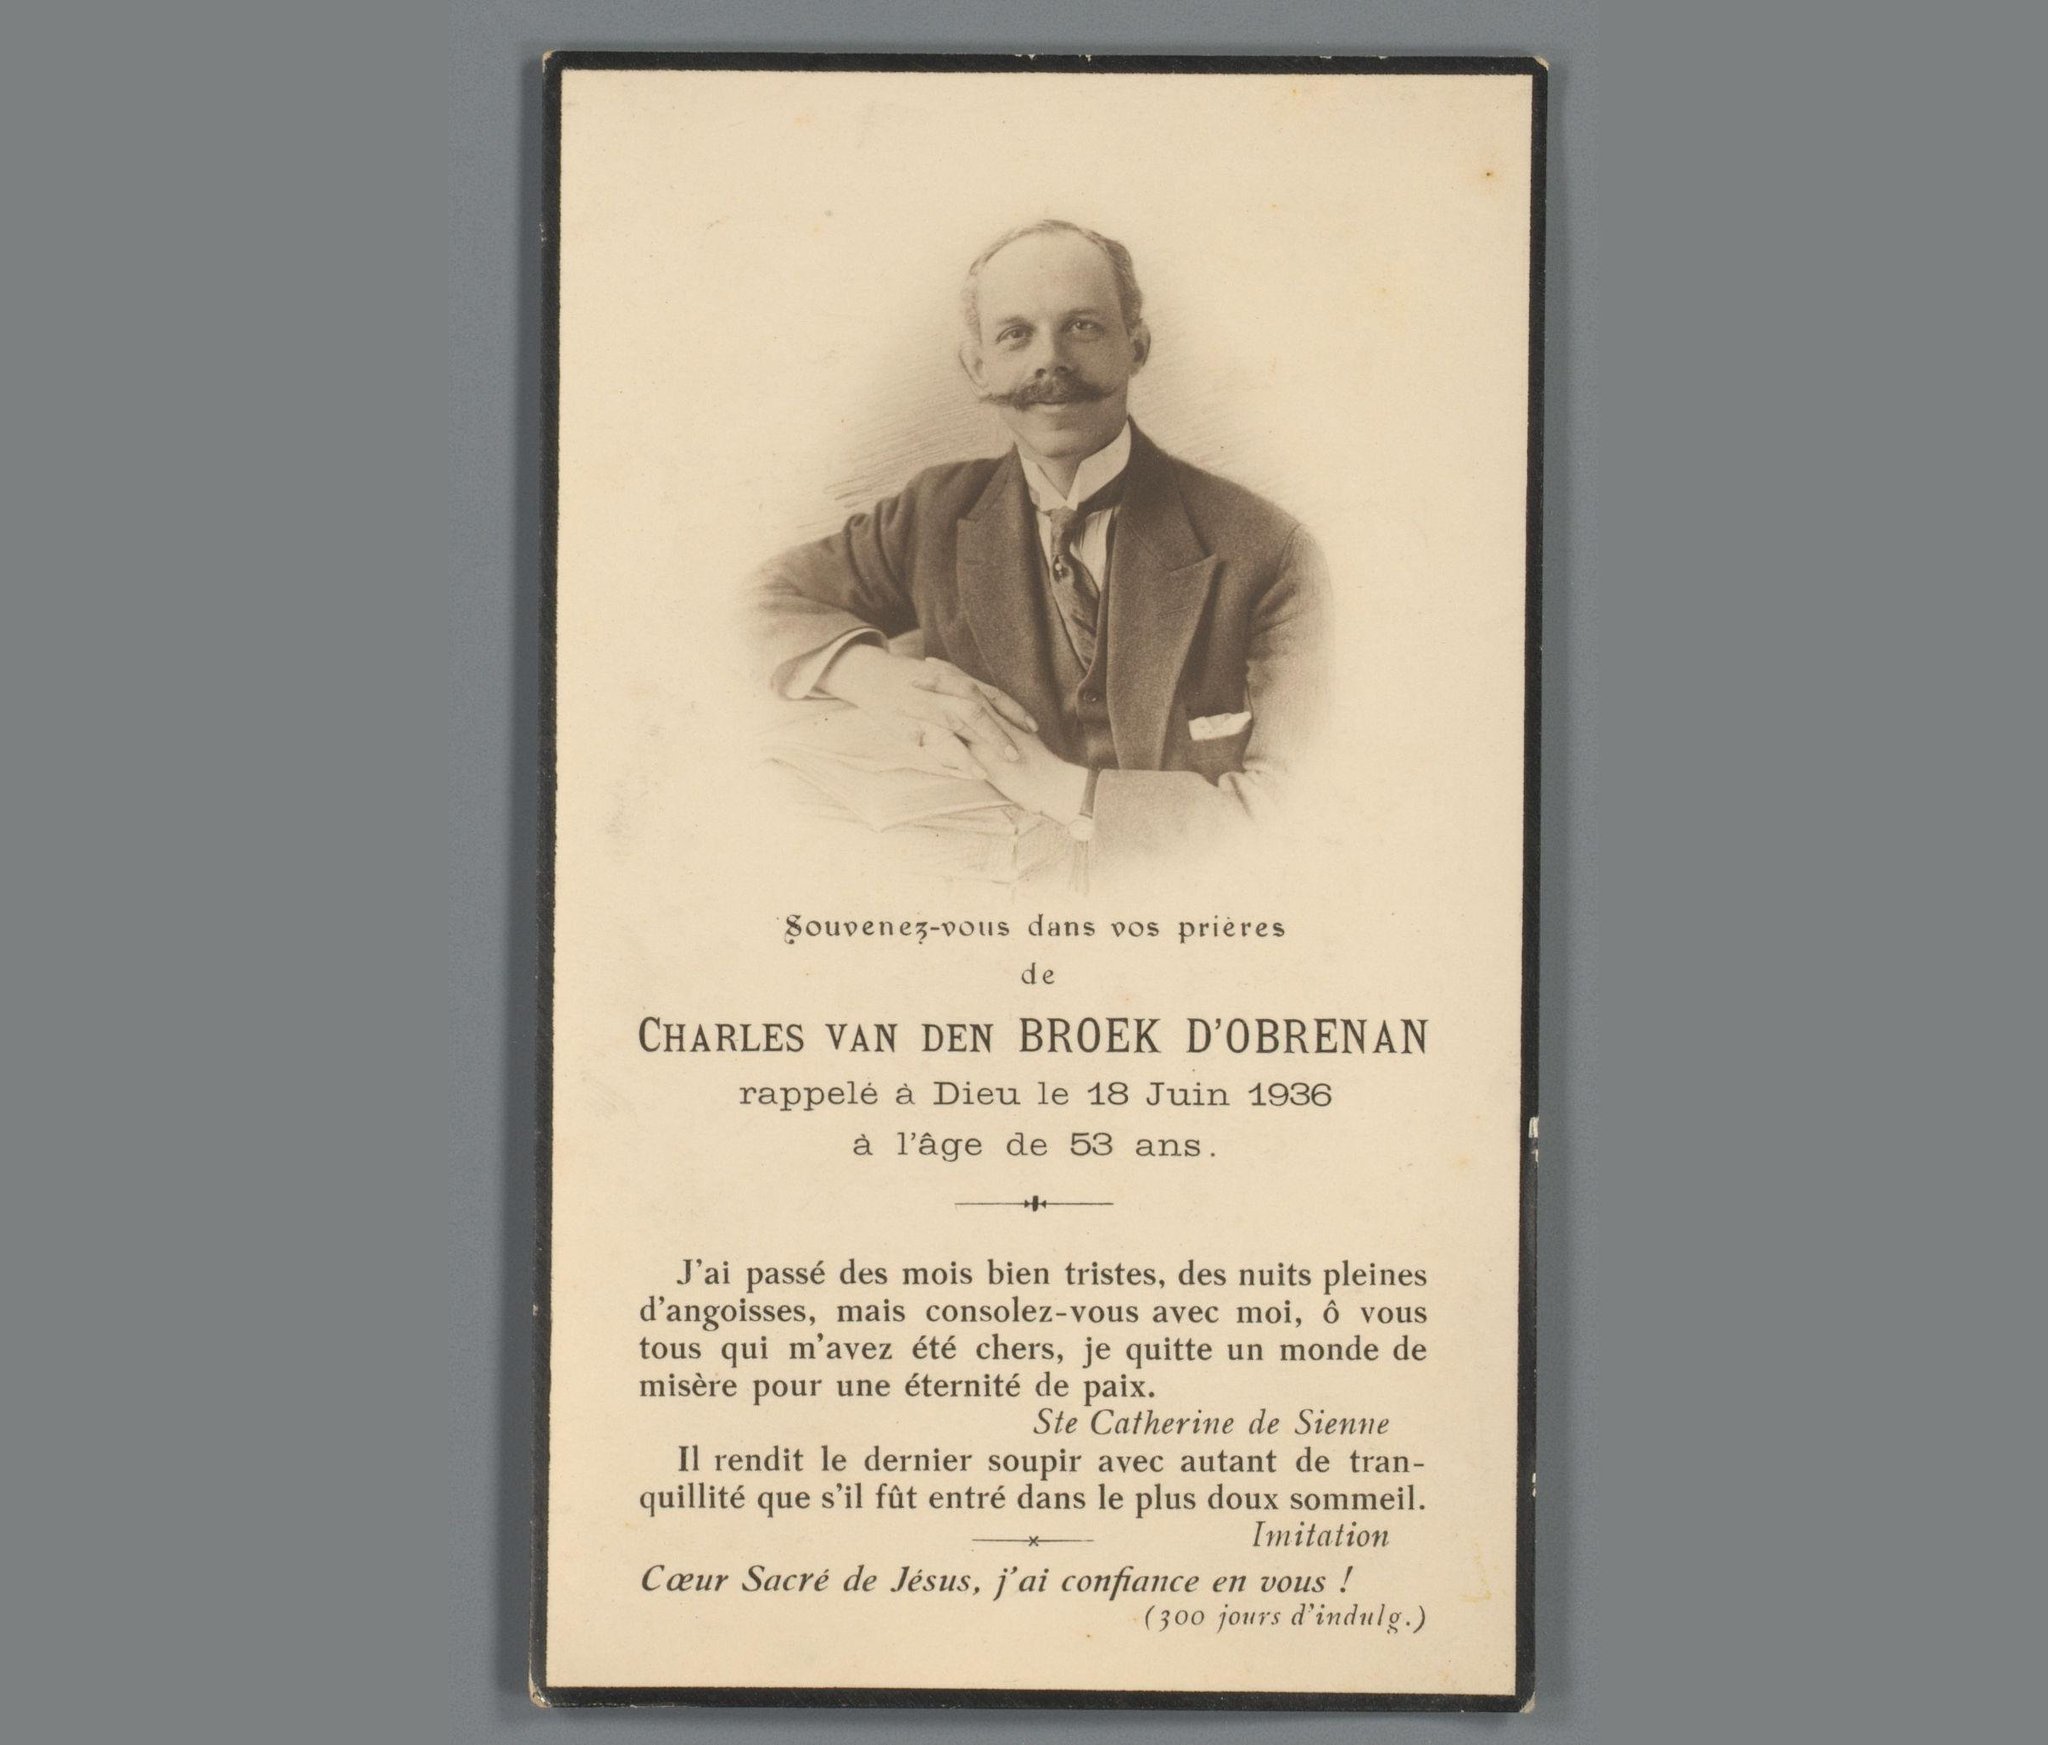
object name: prayer card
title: Bidprent met portret van Charles van den Broek d'Obrenan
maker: Anonymous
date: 1936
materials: paper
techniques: gelatin silver print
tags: historical persons